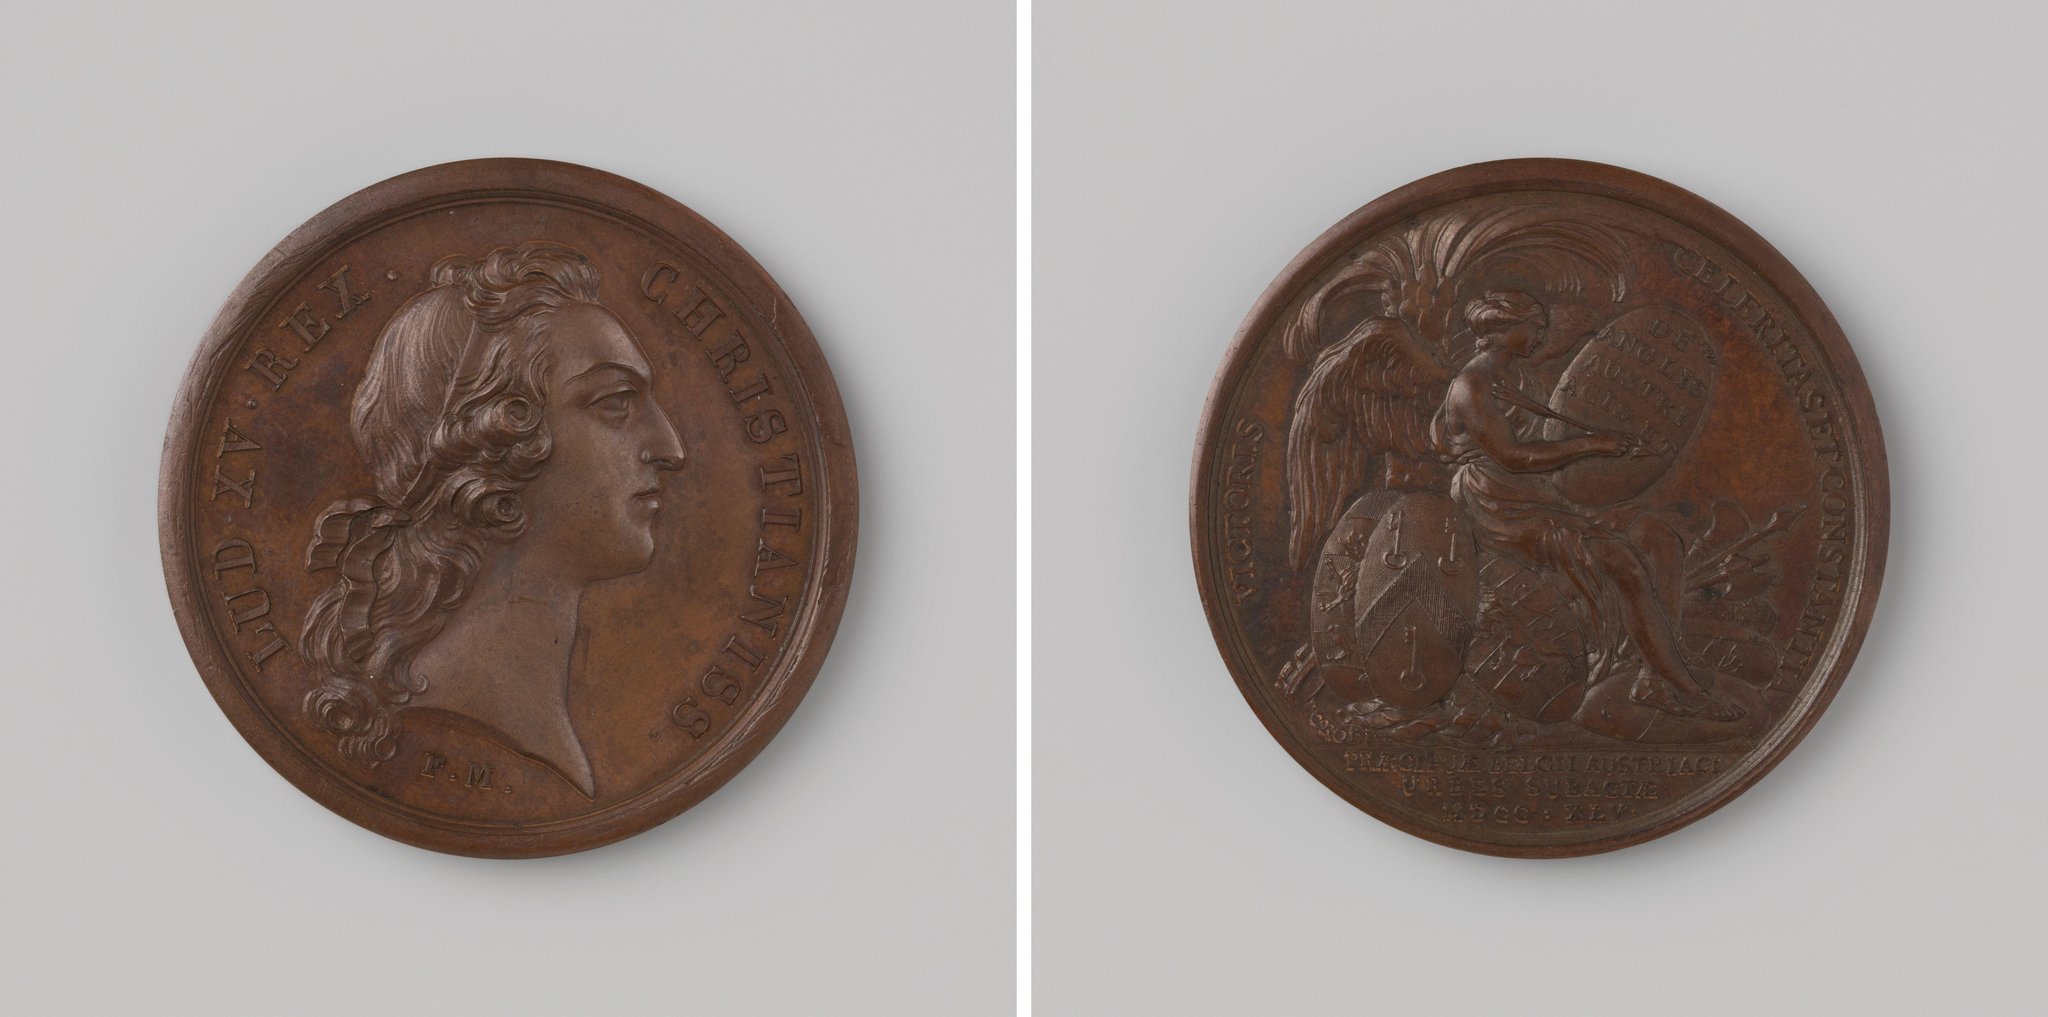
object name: history medal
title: Veldtocht van Lodewijk XV in Vlaanderen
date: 1745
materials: bronze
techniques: striking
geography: paris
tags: louis xv of france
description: Bronzen penning. Voorzijde: borststuk man binnen omschrift. Keerzijde: gevleugelde Overwinning zit onder palmboom temidden van wapentuig en wapenschilden en schrijft een opschrift op een schild binnen omschrift; afsnede: opschrift